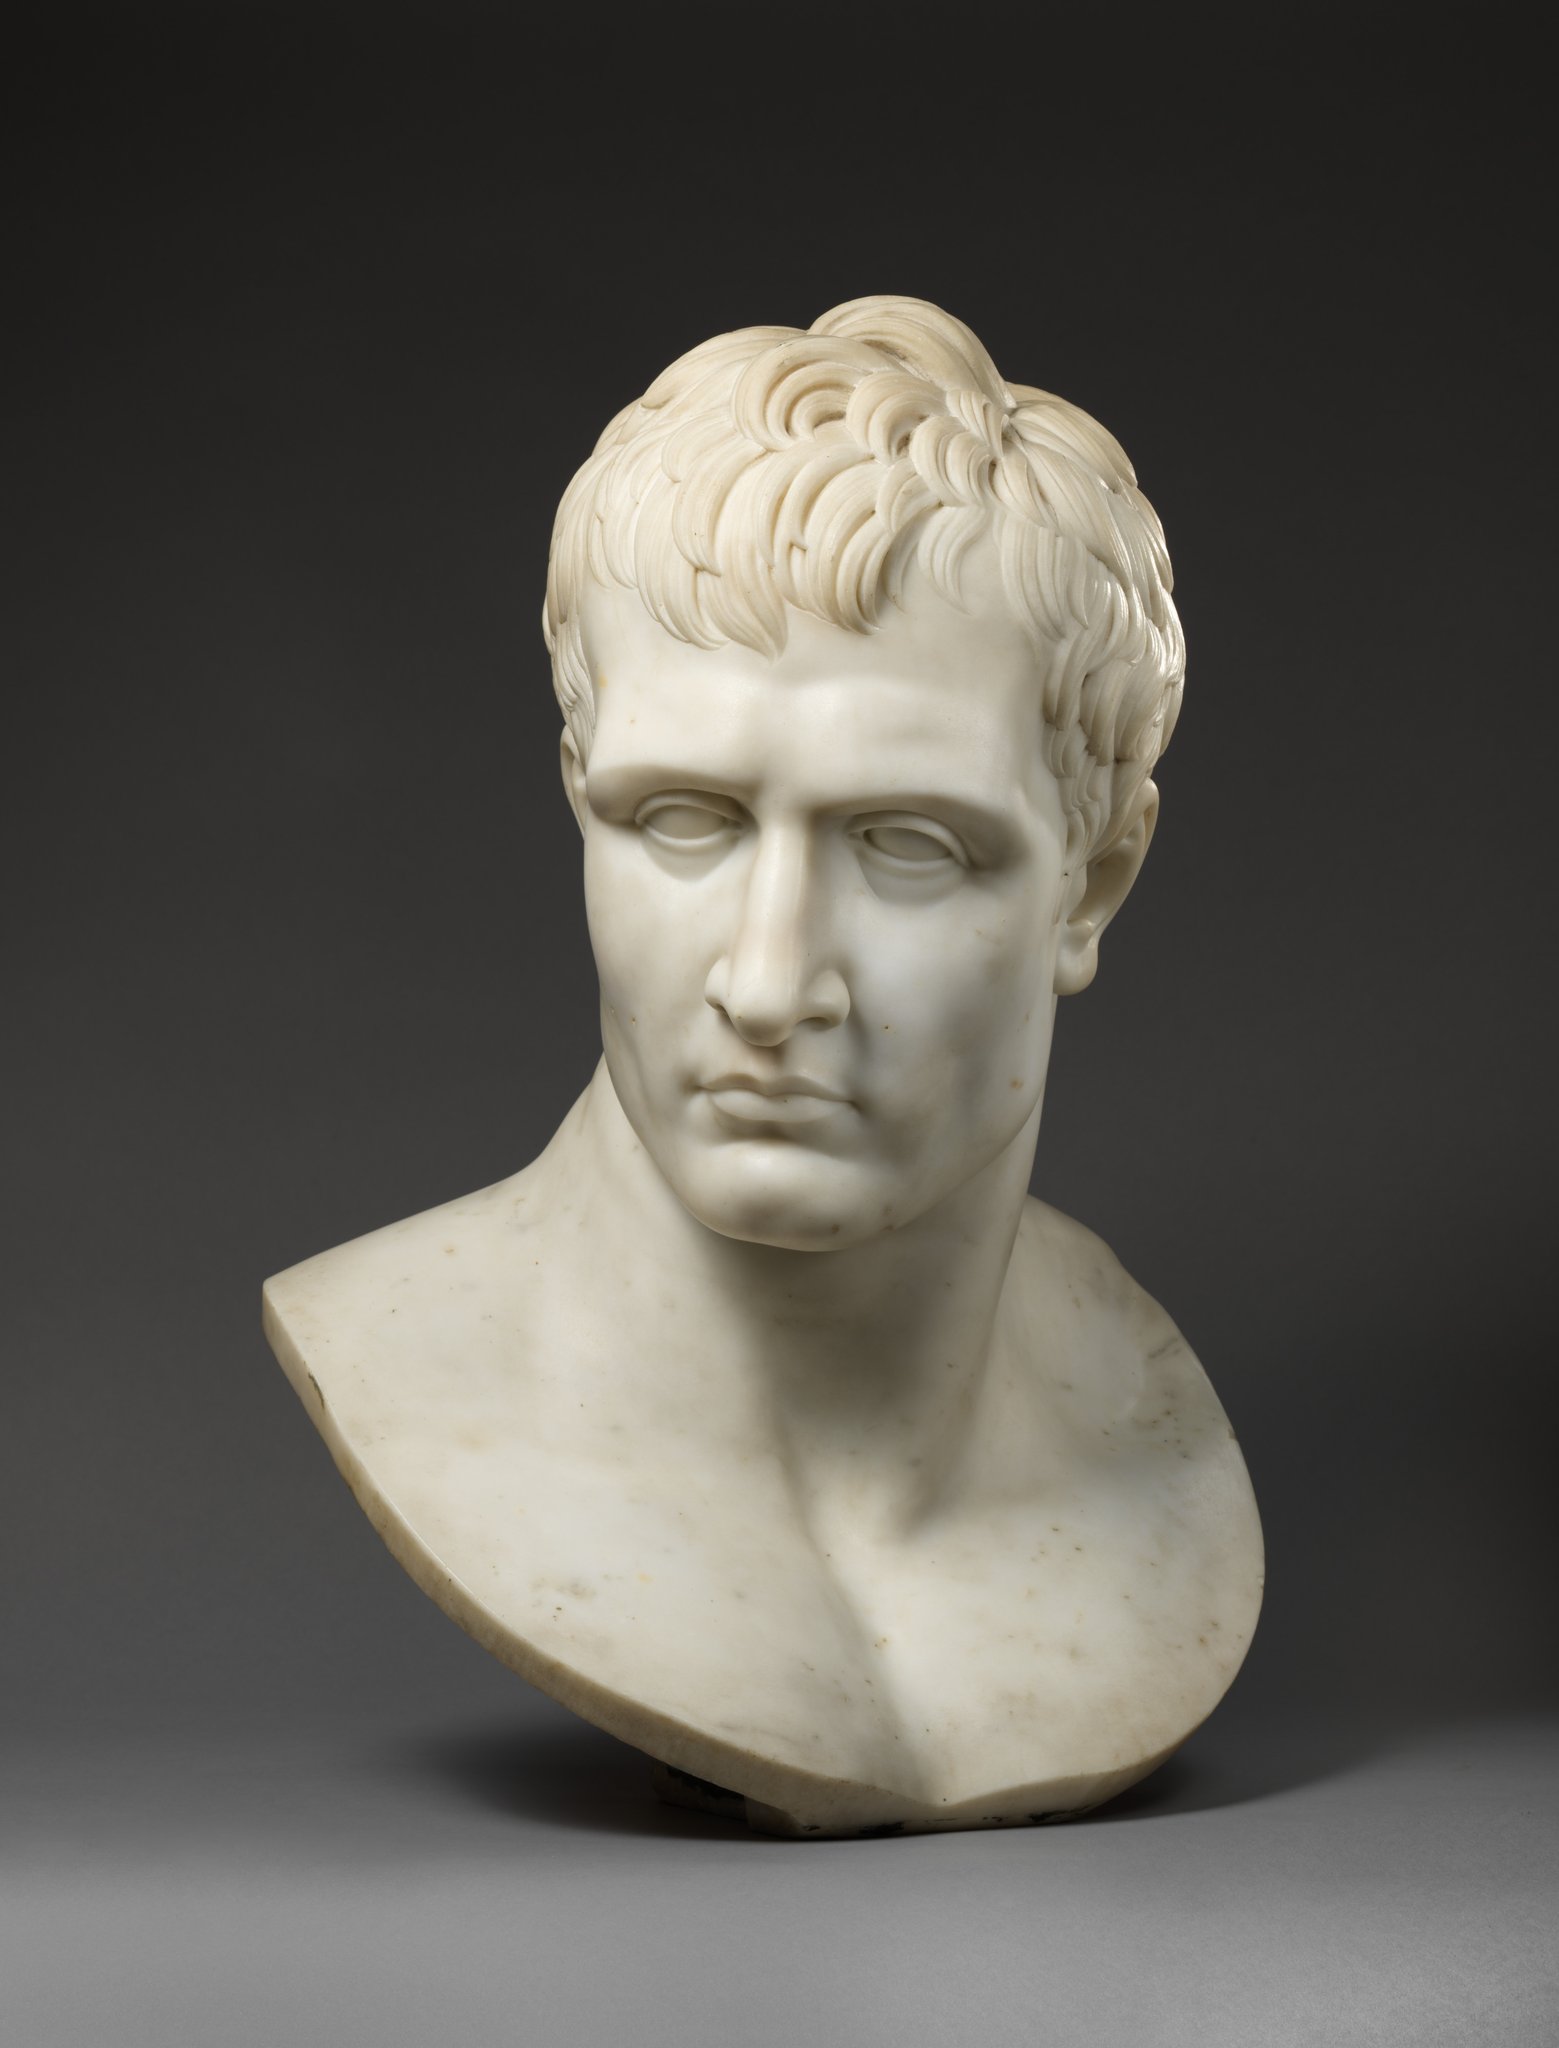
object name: bust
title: Bust of Napoleon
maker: antonio canova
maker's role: maker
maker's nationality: italian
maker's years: 1757-1822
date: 1808-1814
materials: marble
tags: napoleon i